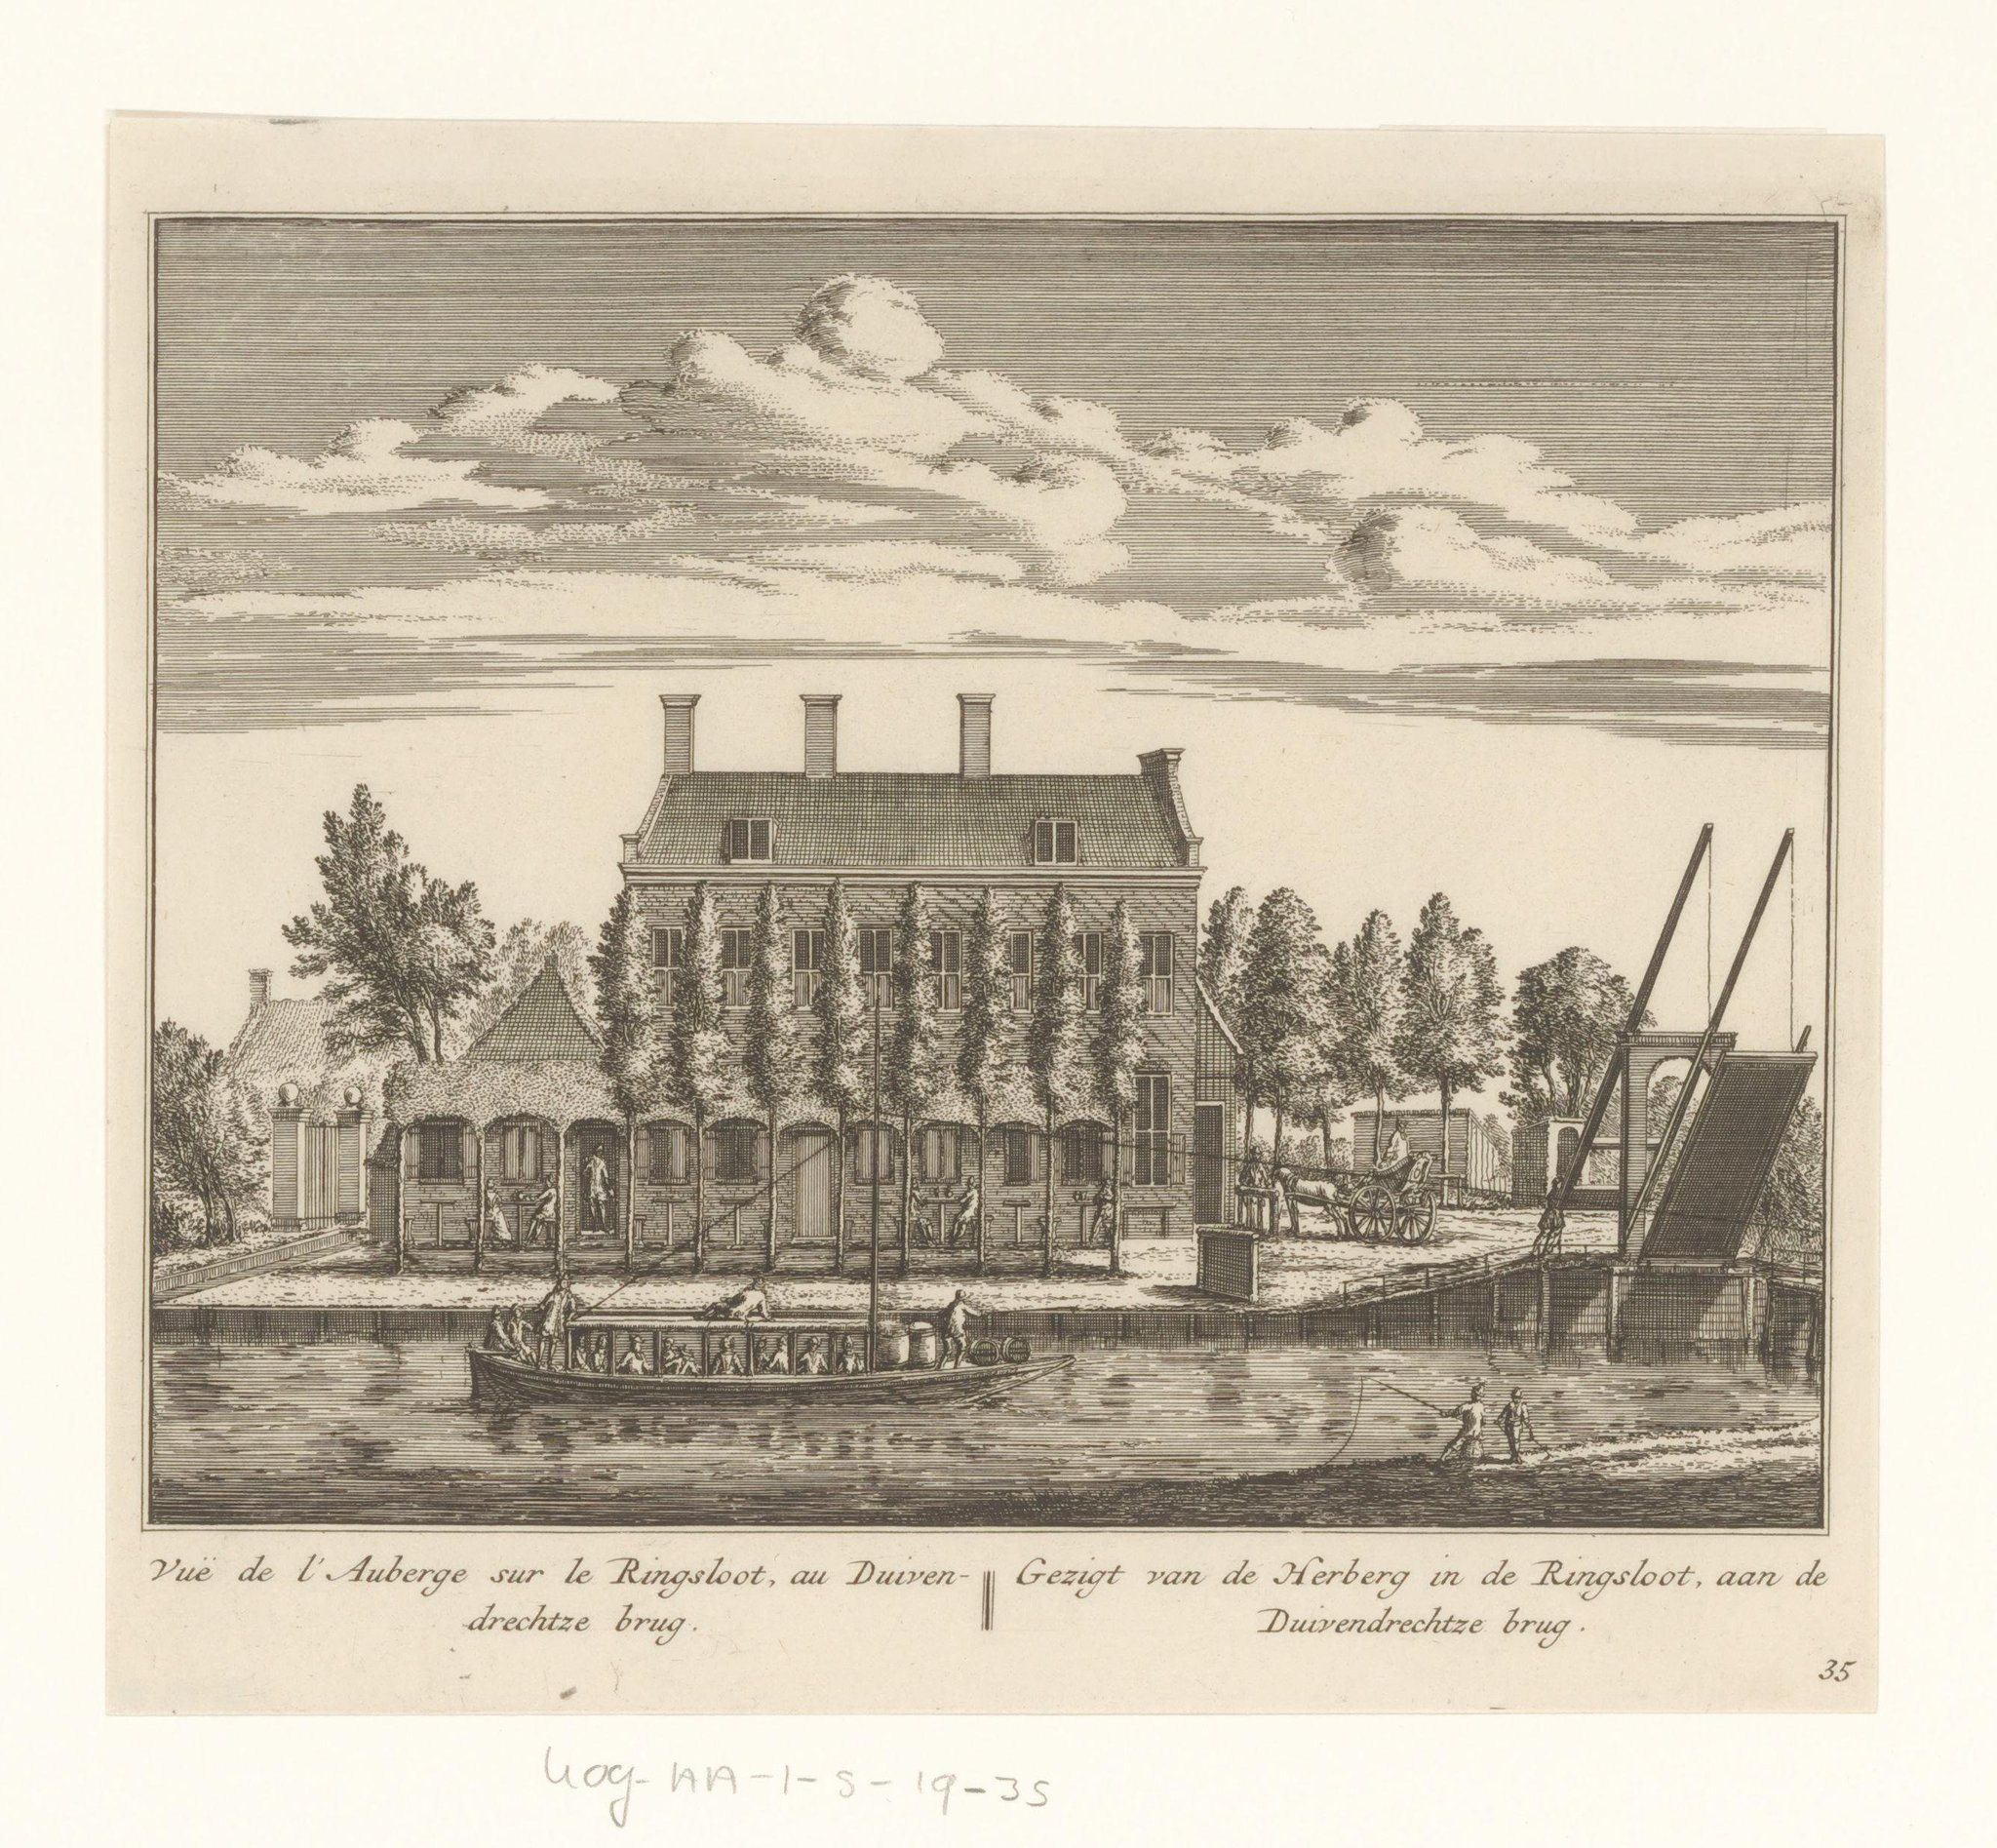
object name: print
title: Hollands Arcadia, of de vermaarde rivier den Amstel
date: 1730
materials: paper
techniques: etching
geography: amsterdam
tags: city-view in general; 'veduta', river, angling, hotel, hostelry, inn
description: Prent waarschijnlijk uit: Tijsens, Gijsbert. Hollands Arcadia, of de vermaarde rivier den Amstel (...) naar 't léven getekend en in 't ligt gebragt door Abraham Rademaker (...). Amsterdam: Leonardus Schenk, 1730.